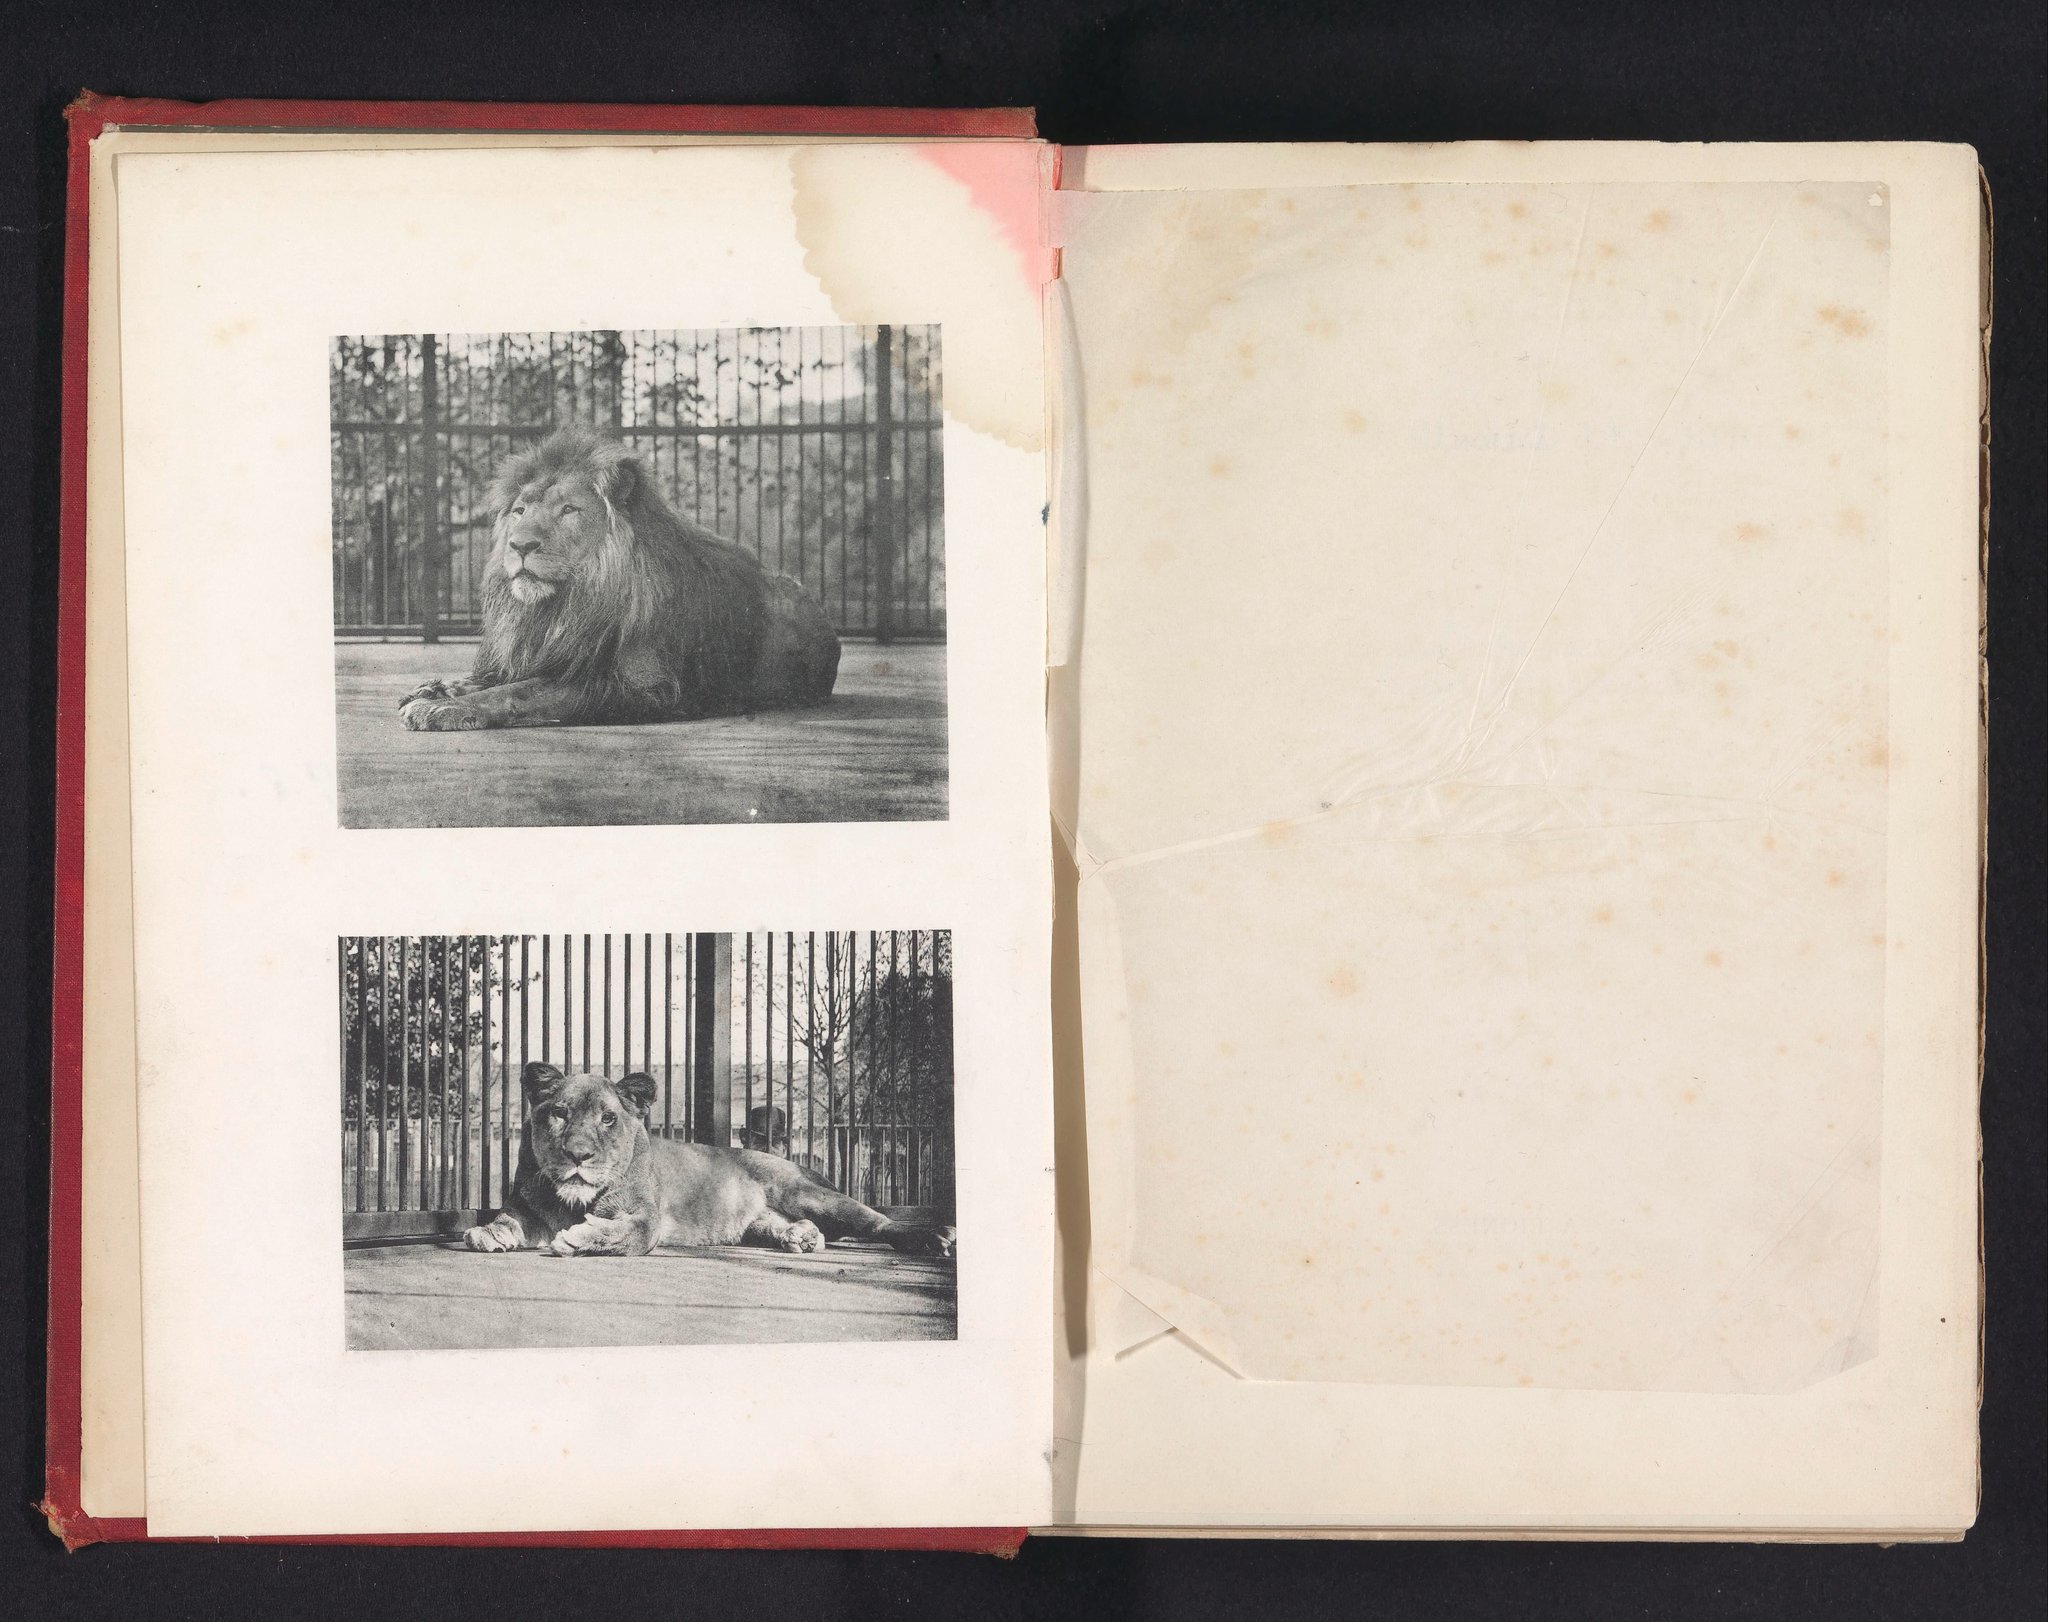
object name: photomechanical print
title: A lion, A Lioness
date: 1876-1886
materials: paper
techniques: photograph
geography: paris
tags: beasts of prey, predatory animals: lion